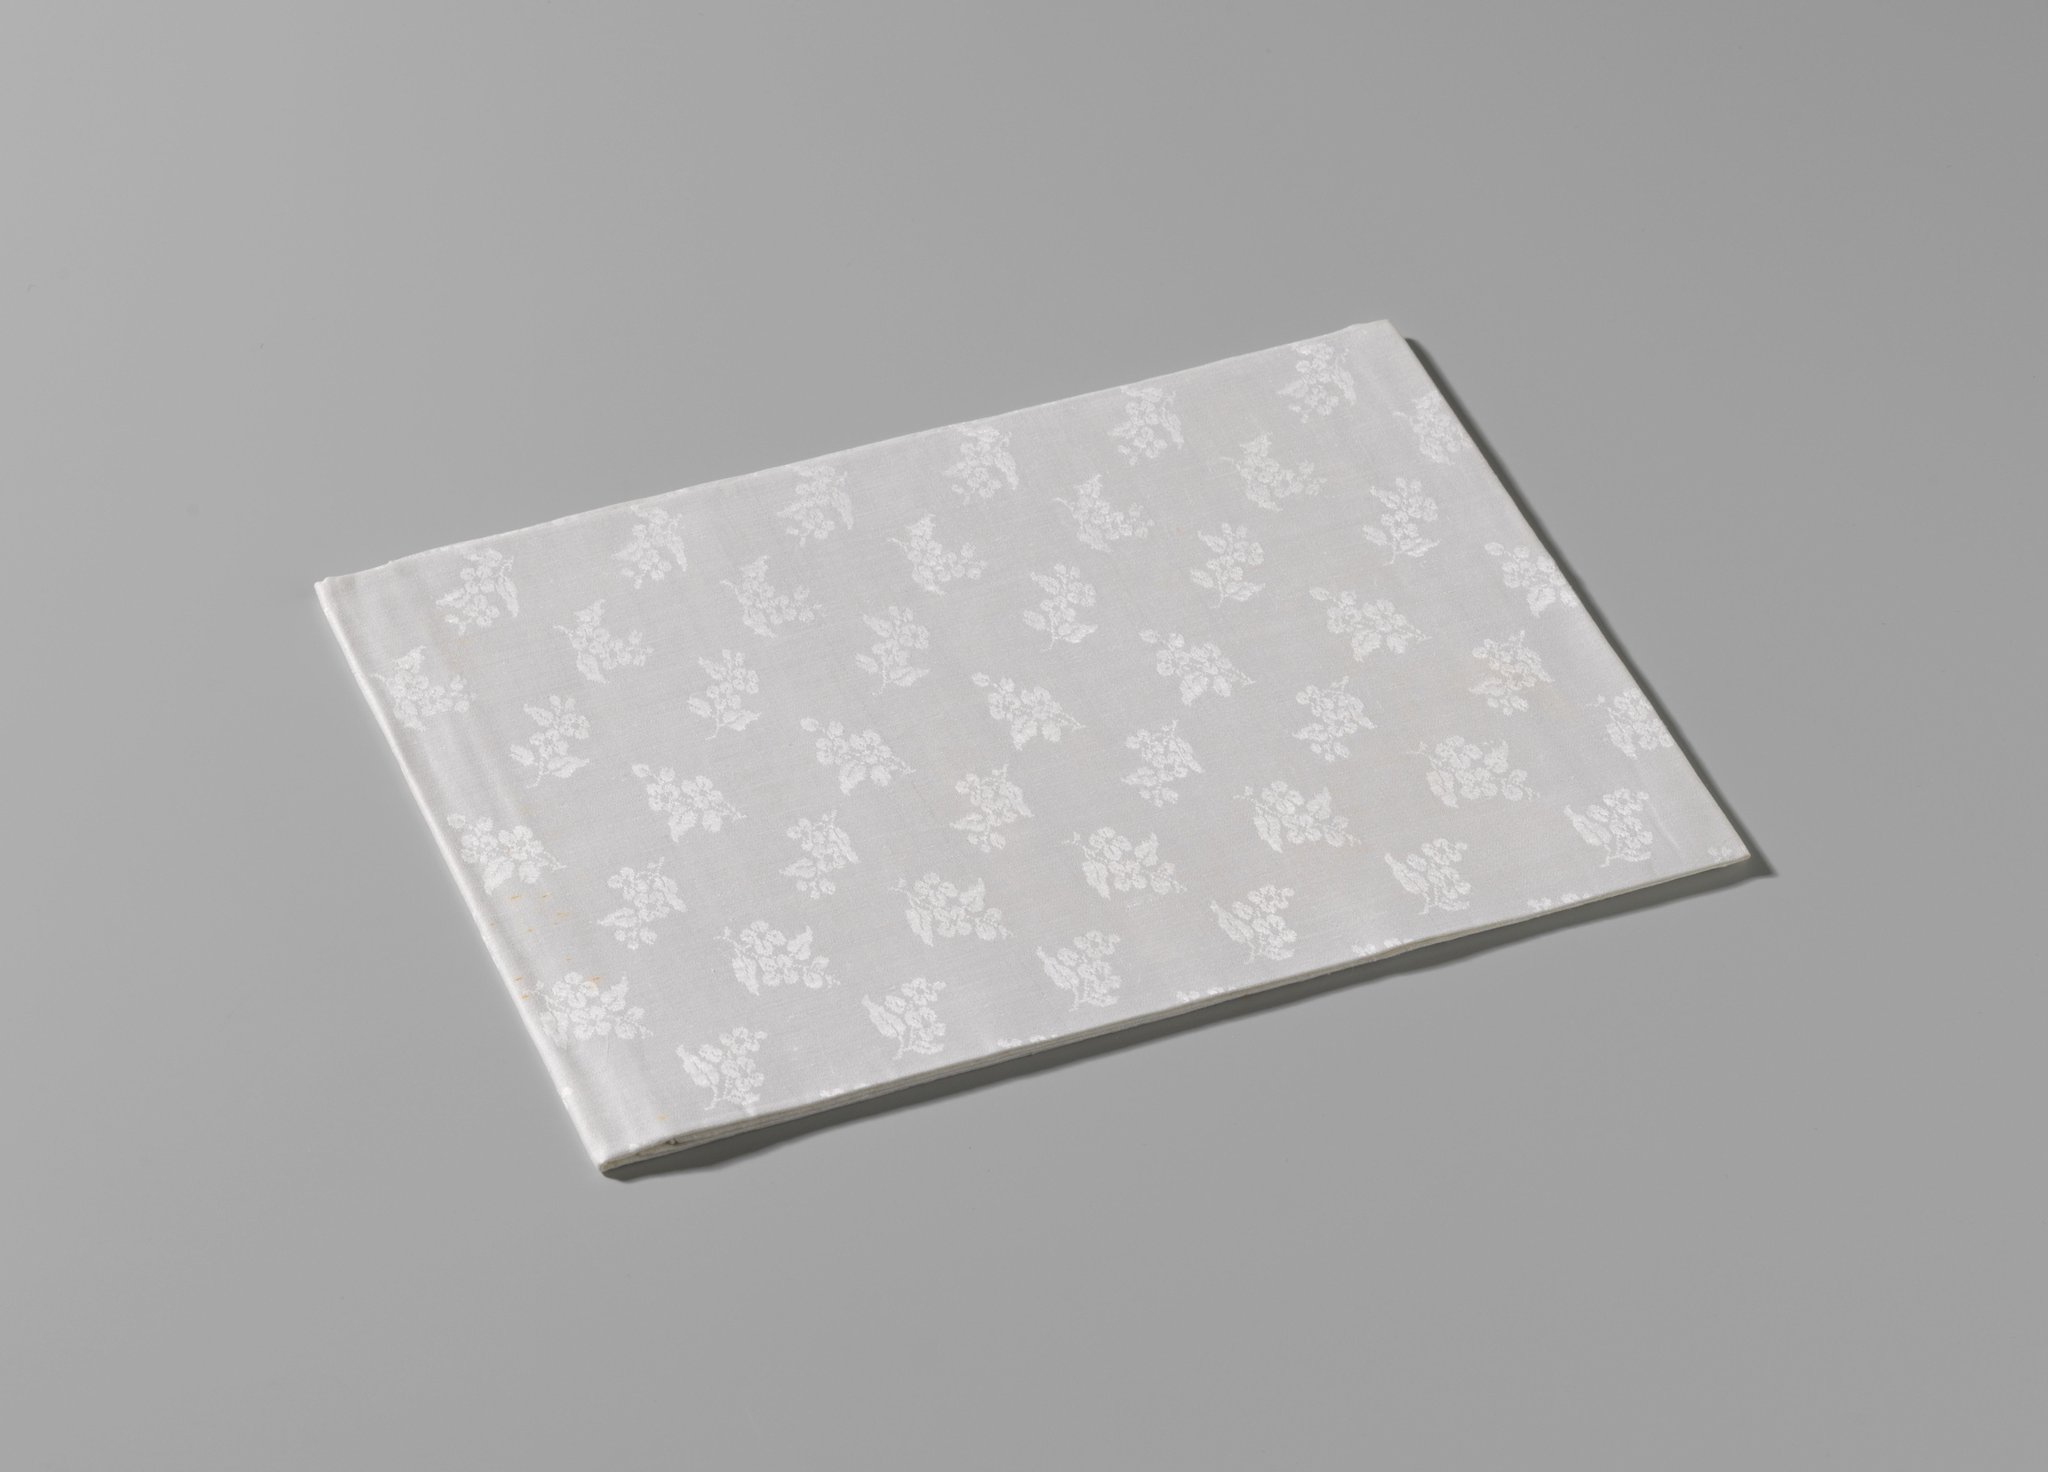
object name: napkin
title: Servet met strooibloemen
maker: Anonymous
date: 1700-1899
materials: linen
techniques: damask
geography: saxony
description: Vergelijk E. Kumsch, Leinendamastmuster des XVII. und XVIII. Jahrhunderts, Dresden 1891, Taf. 9,1.